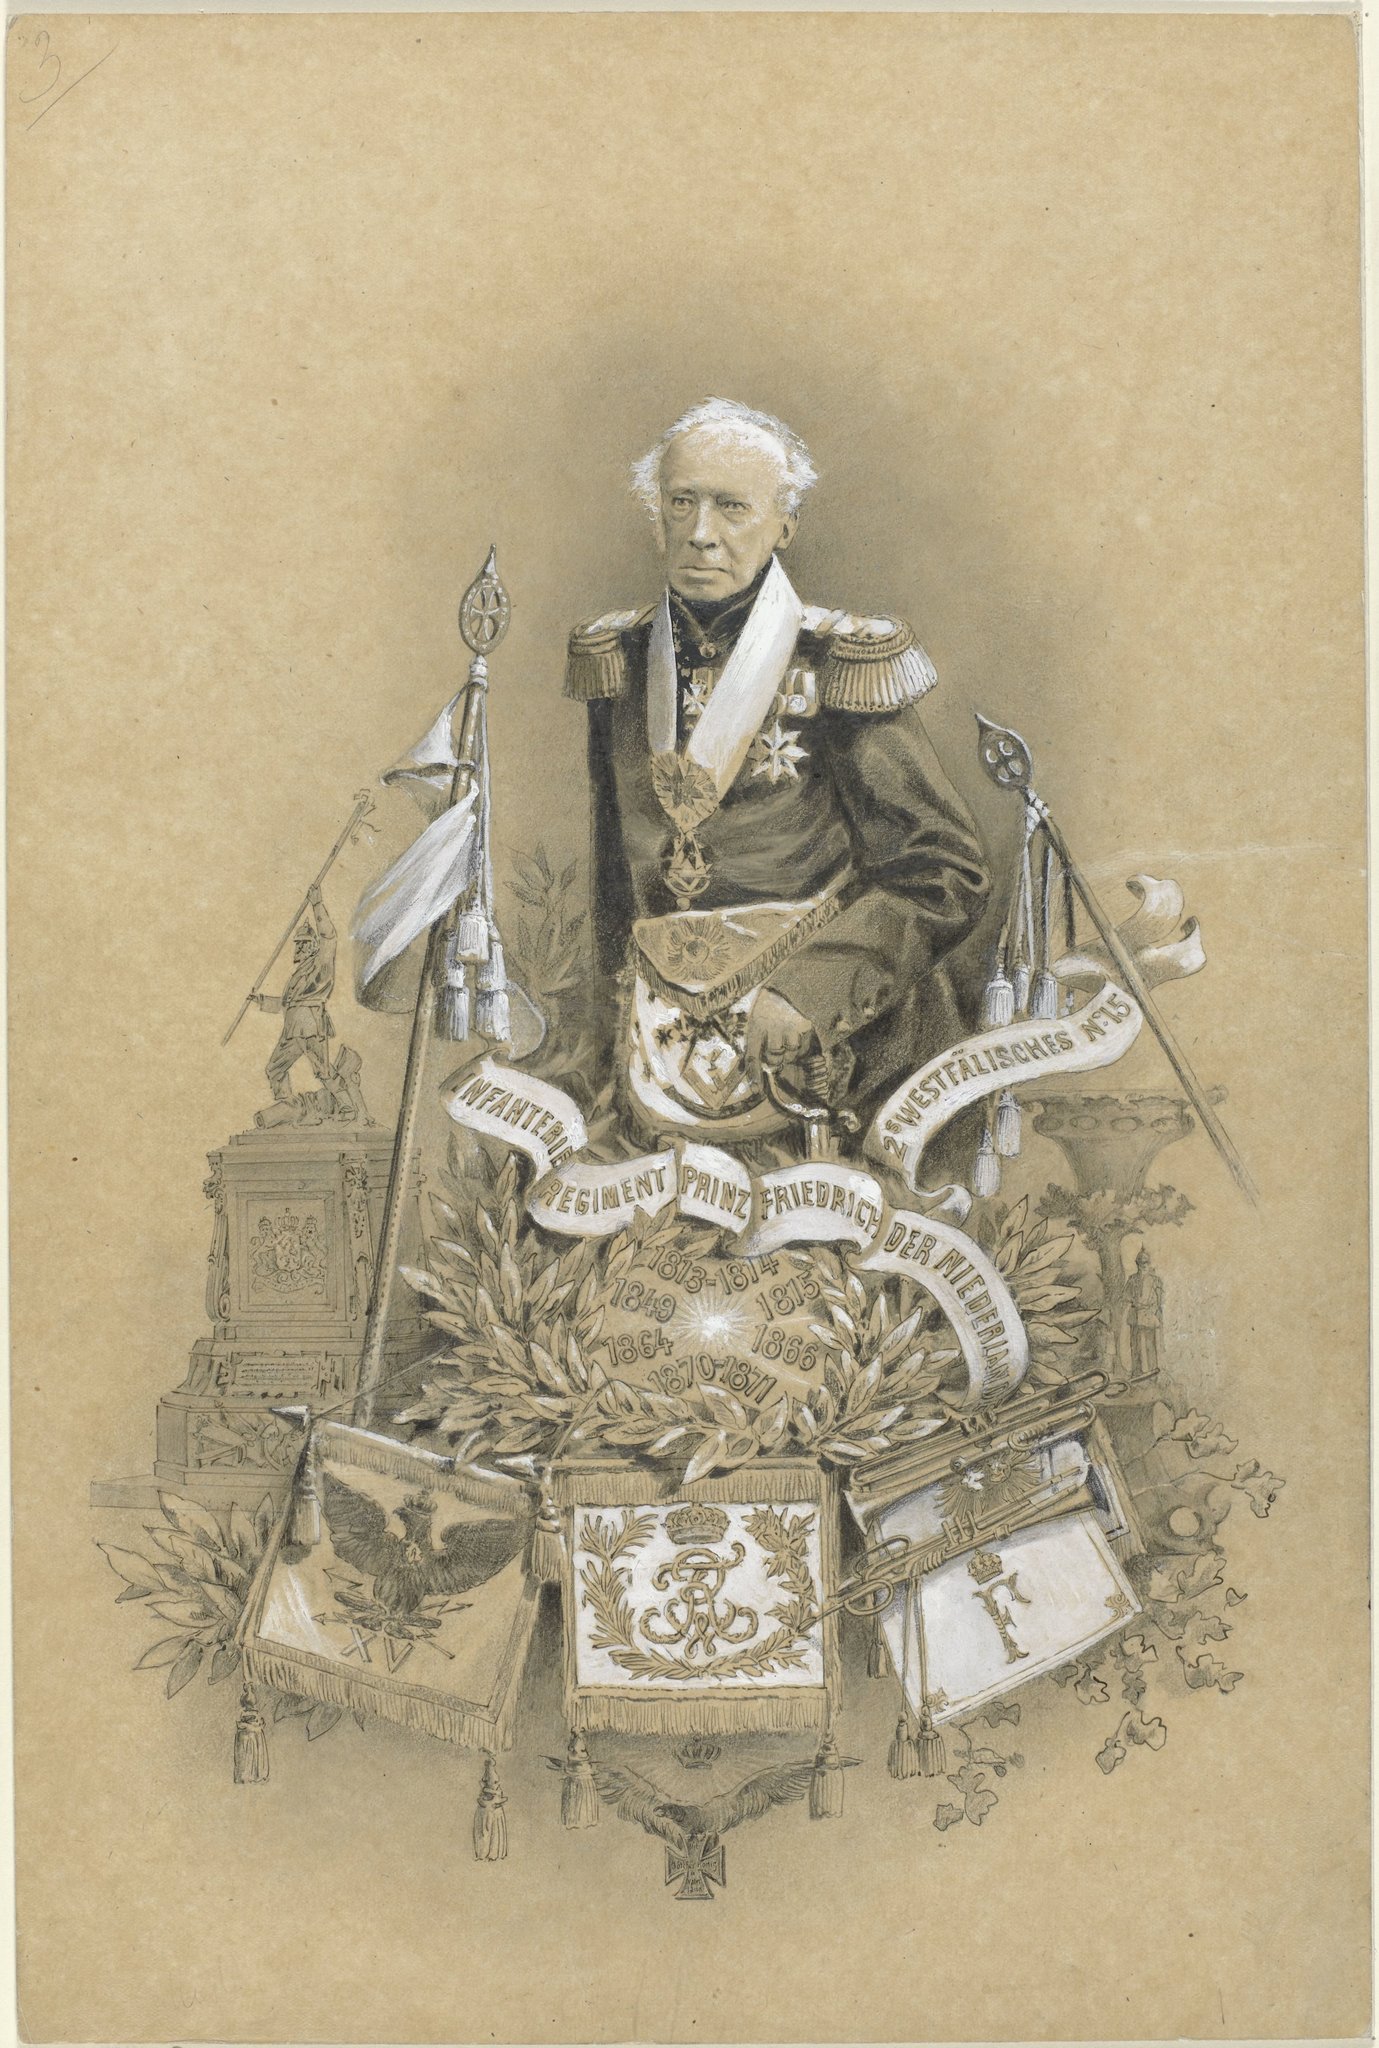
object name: drawing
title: Portret van Frederik, prins der Nederlanden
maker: Anonymous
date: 1871-1931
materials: cardboard, ink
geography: netherlands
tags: berlin, frederik (prins der nederlanden), monument, statue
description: Portret van Frederik. Daar omheen een aantal allegorische objecten, waaronder drie vaandels, lauwerbladen, een zwarte adelaar en een standbeeld. In het midden een aantal jaartallen en een banderol met 'Infanterie Regiment Prinz Friedrich der Niederlande 2s Westfälisches No. 15'.